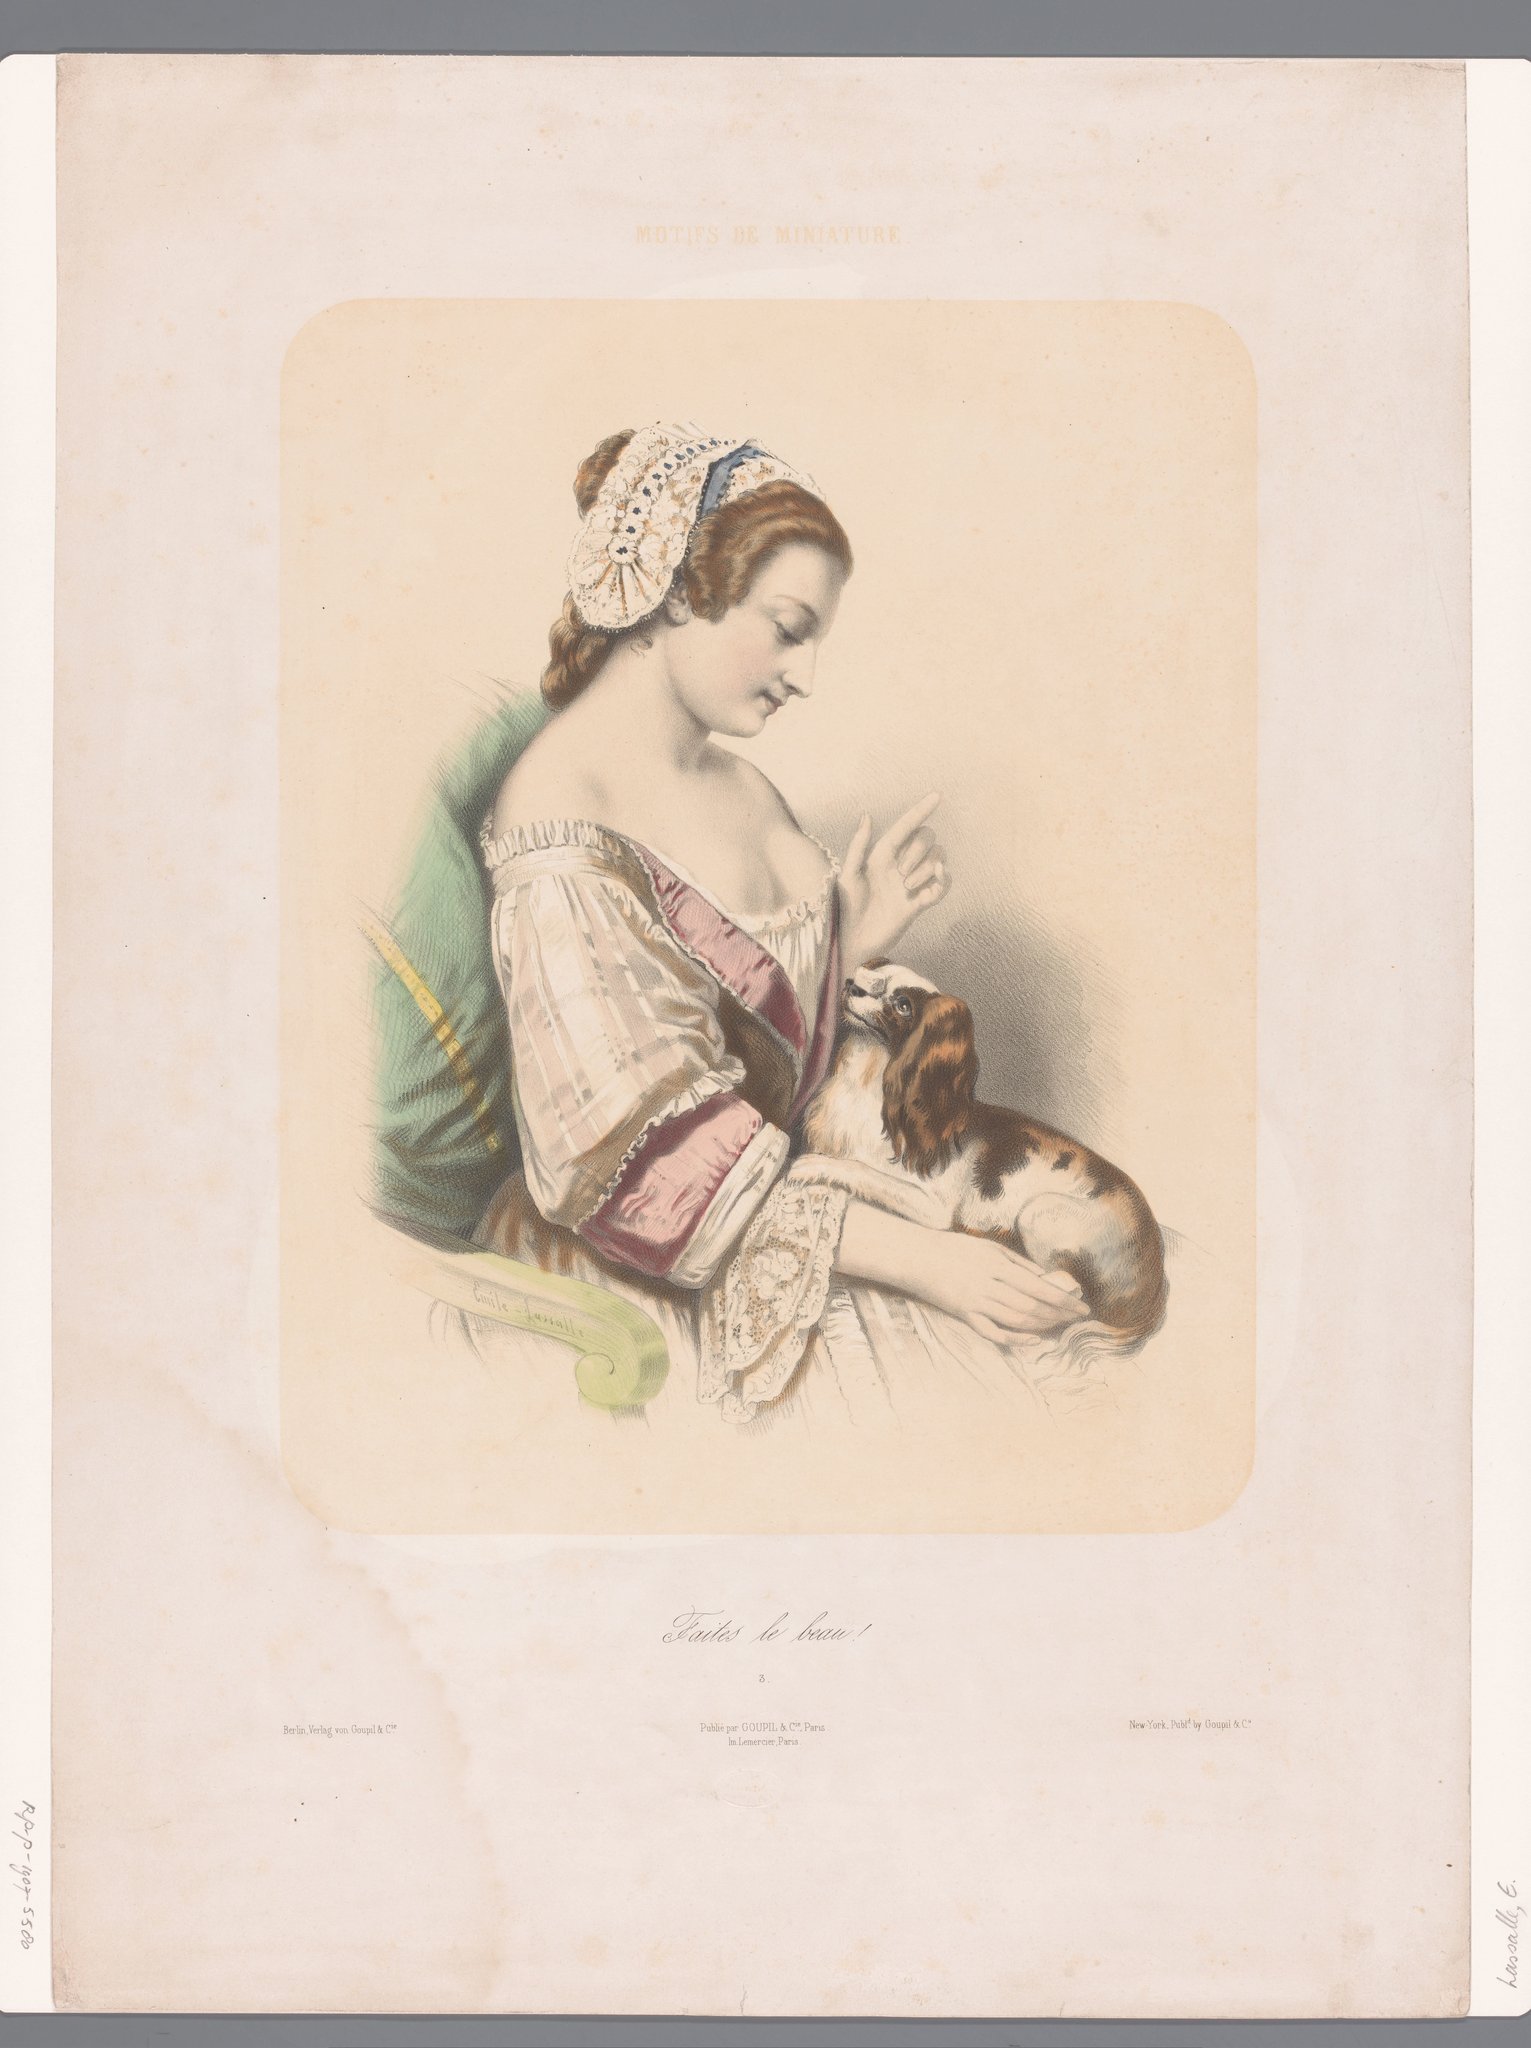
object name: print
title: Jonge vrouw traint haar schoothond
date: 1855-1858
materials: paper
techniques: hand coloring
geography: paris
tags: training of performing dog, sitting figure - aa - female human figure, dog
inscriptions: collector's mark: Lugt 2228a, check stamp: Lugt 1090